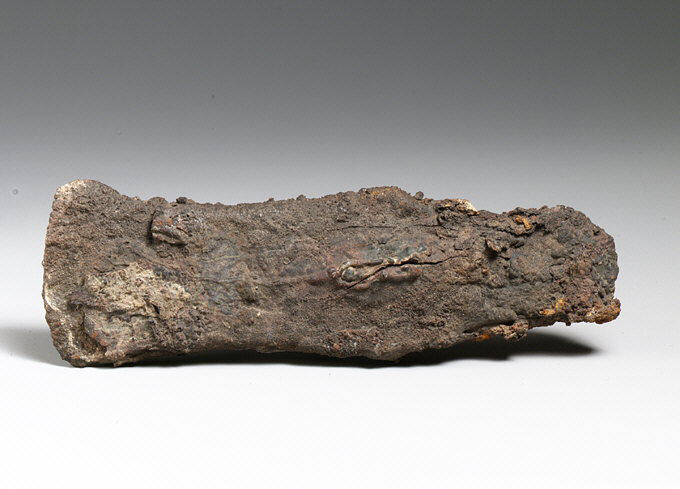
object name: axehead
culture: cypriot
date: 3200-2000 BCE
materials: iron